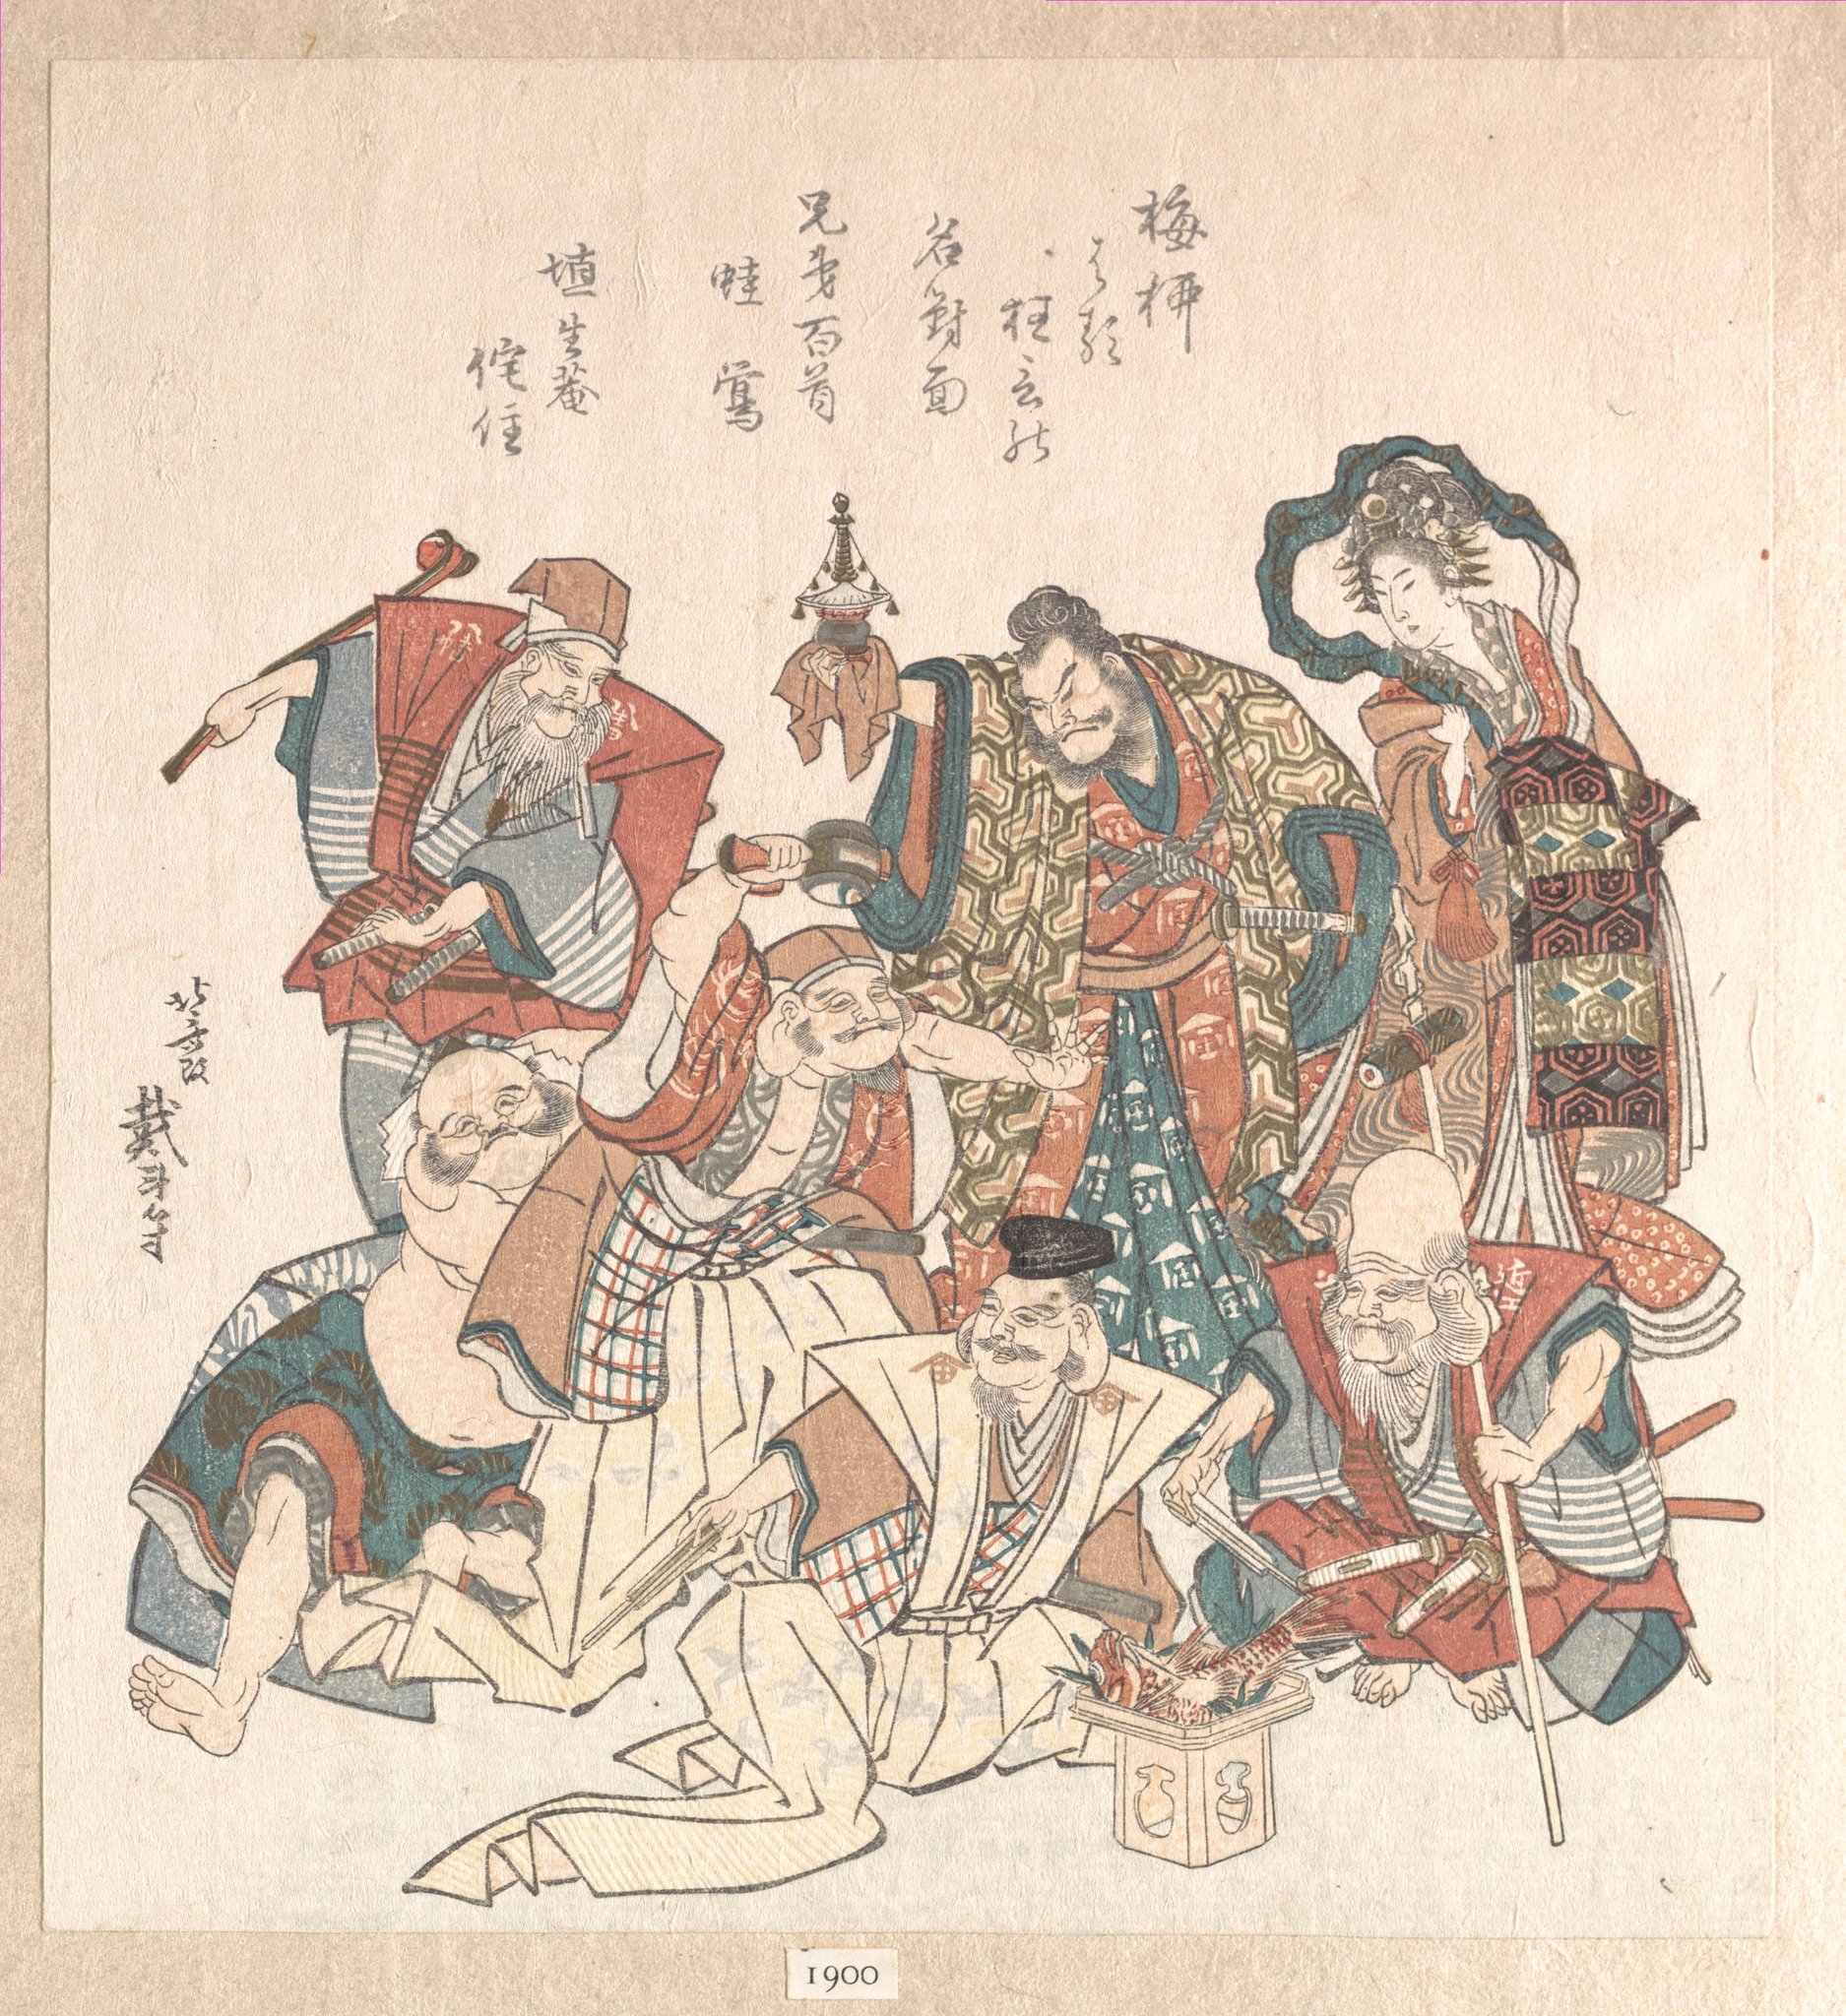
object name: print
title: Seven Gods of Good Fortune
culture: japanese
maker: katsushika hokusai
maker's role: artist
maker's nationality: japanese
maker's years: 1760-1849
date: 1808-1827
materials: ink, paper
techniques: surimono, woodblock print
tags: men,women